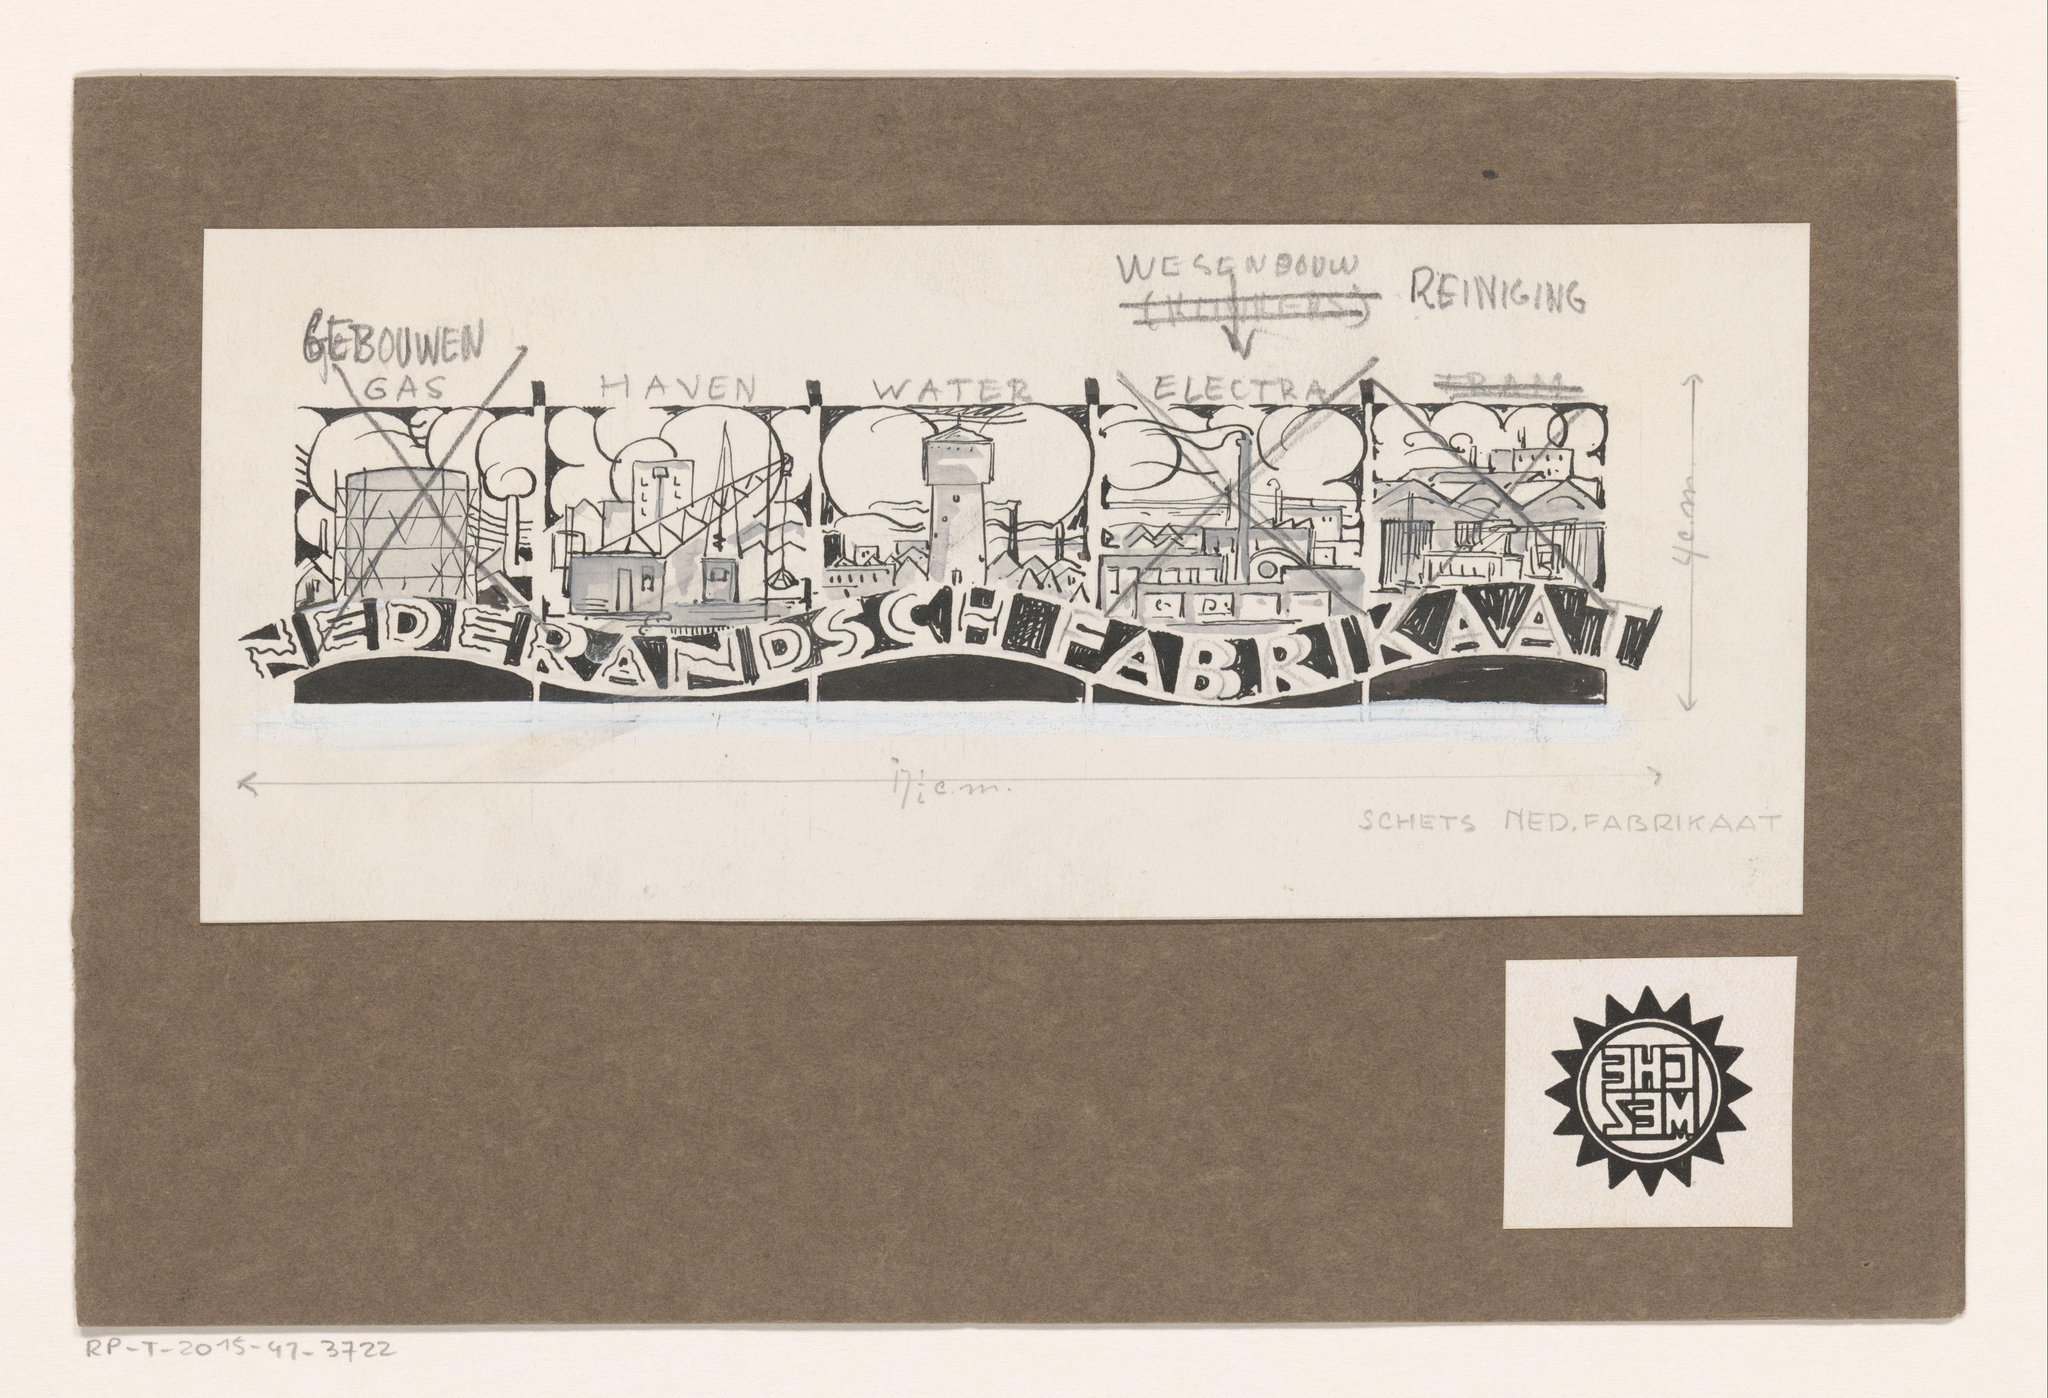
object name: photomechanical print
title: Vijf Nederlandse industrieën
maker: Anonymous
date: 1915-1970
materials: paint, ink, paper, pencil, watercolor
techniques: brush, pen, printing block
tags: industries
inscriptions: annotation: ‘GEBOUWEN/ GAS/ HAVEN/ WATER/ WEGENBOUW/ ELECTRA/ REINIGING/ 4 cm/ 17 1/2 cm/ SCHETS NED. FABRIKAAT’, collector's mark: Lugt 2228a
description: De vijf belangrijkste Nederlandse industrieën, te weten gas, haven, water, elektra en reiniging met bijbehorende gebouwen zoals een watertoren en energiecentrale. Tevens een vignet met de letters CHE MES in spiegelbeeld in een zon.